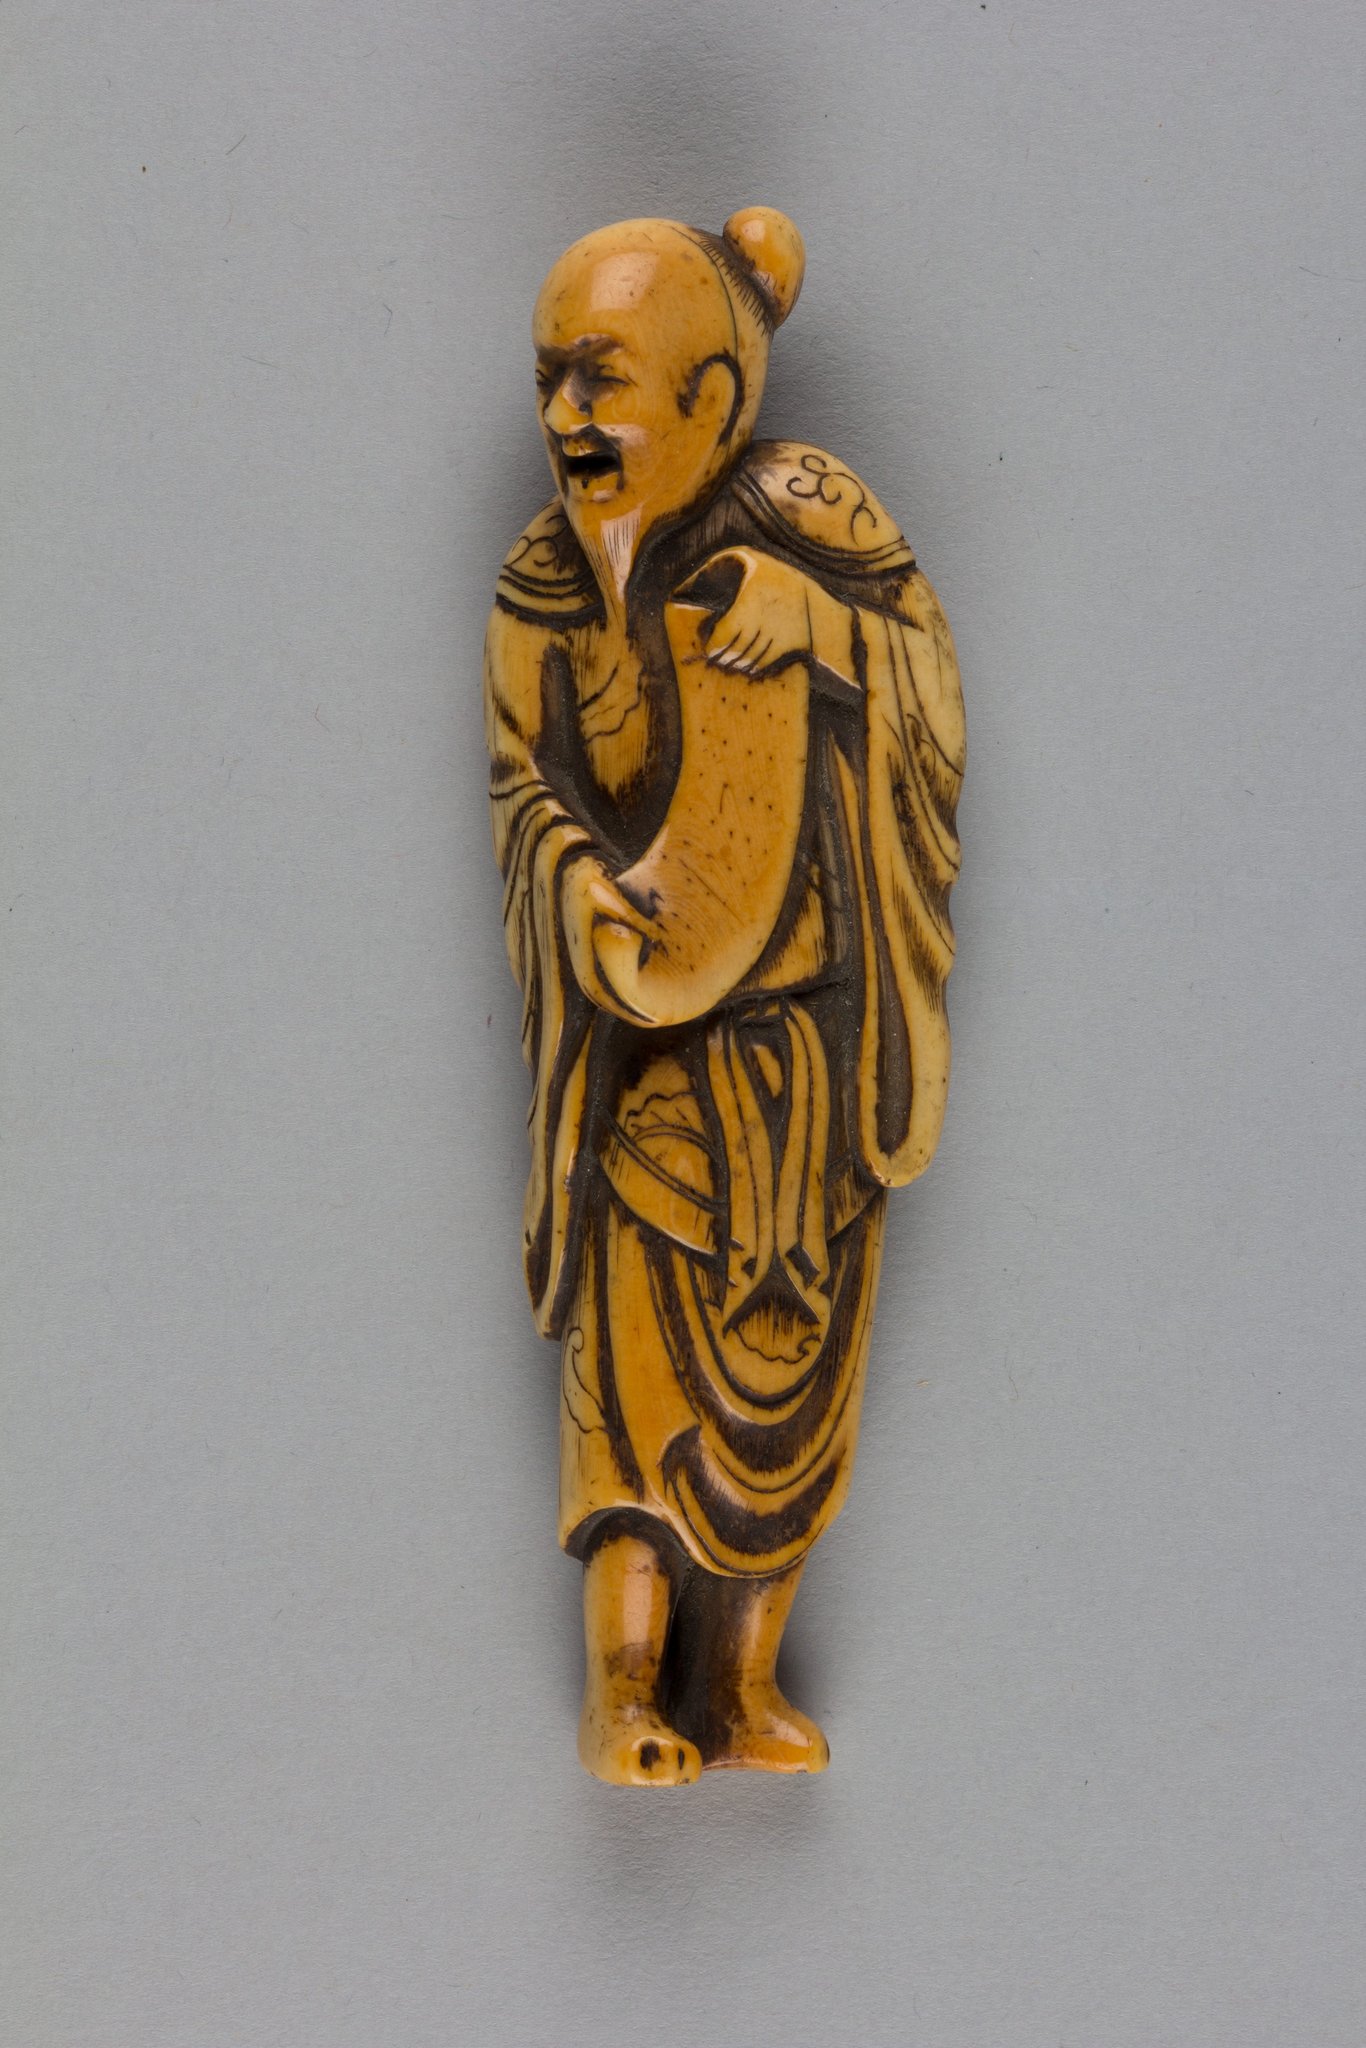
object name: netsuke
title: Netsuke of Man Holding a Scroll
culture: japanese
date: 1801-1900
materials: ivory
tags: scrolls,men